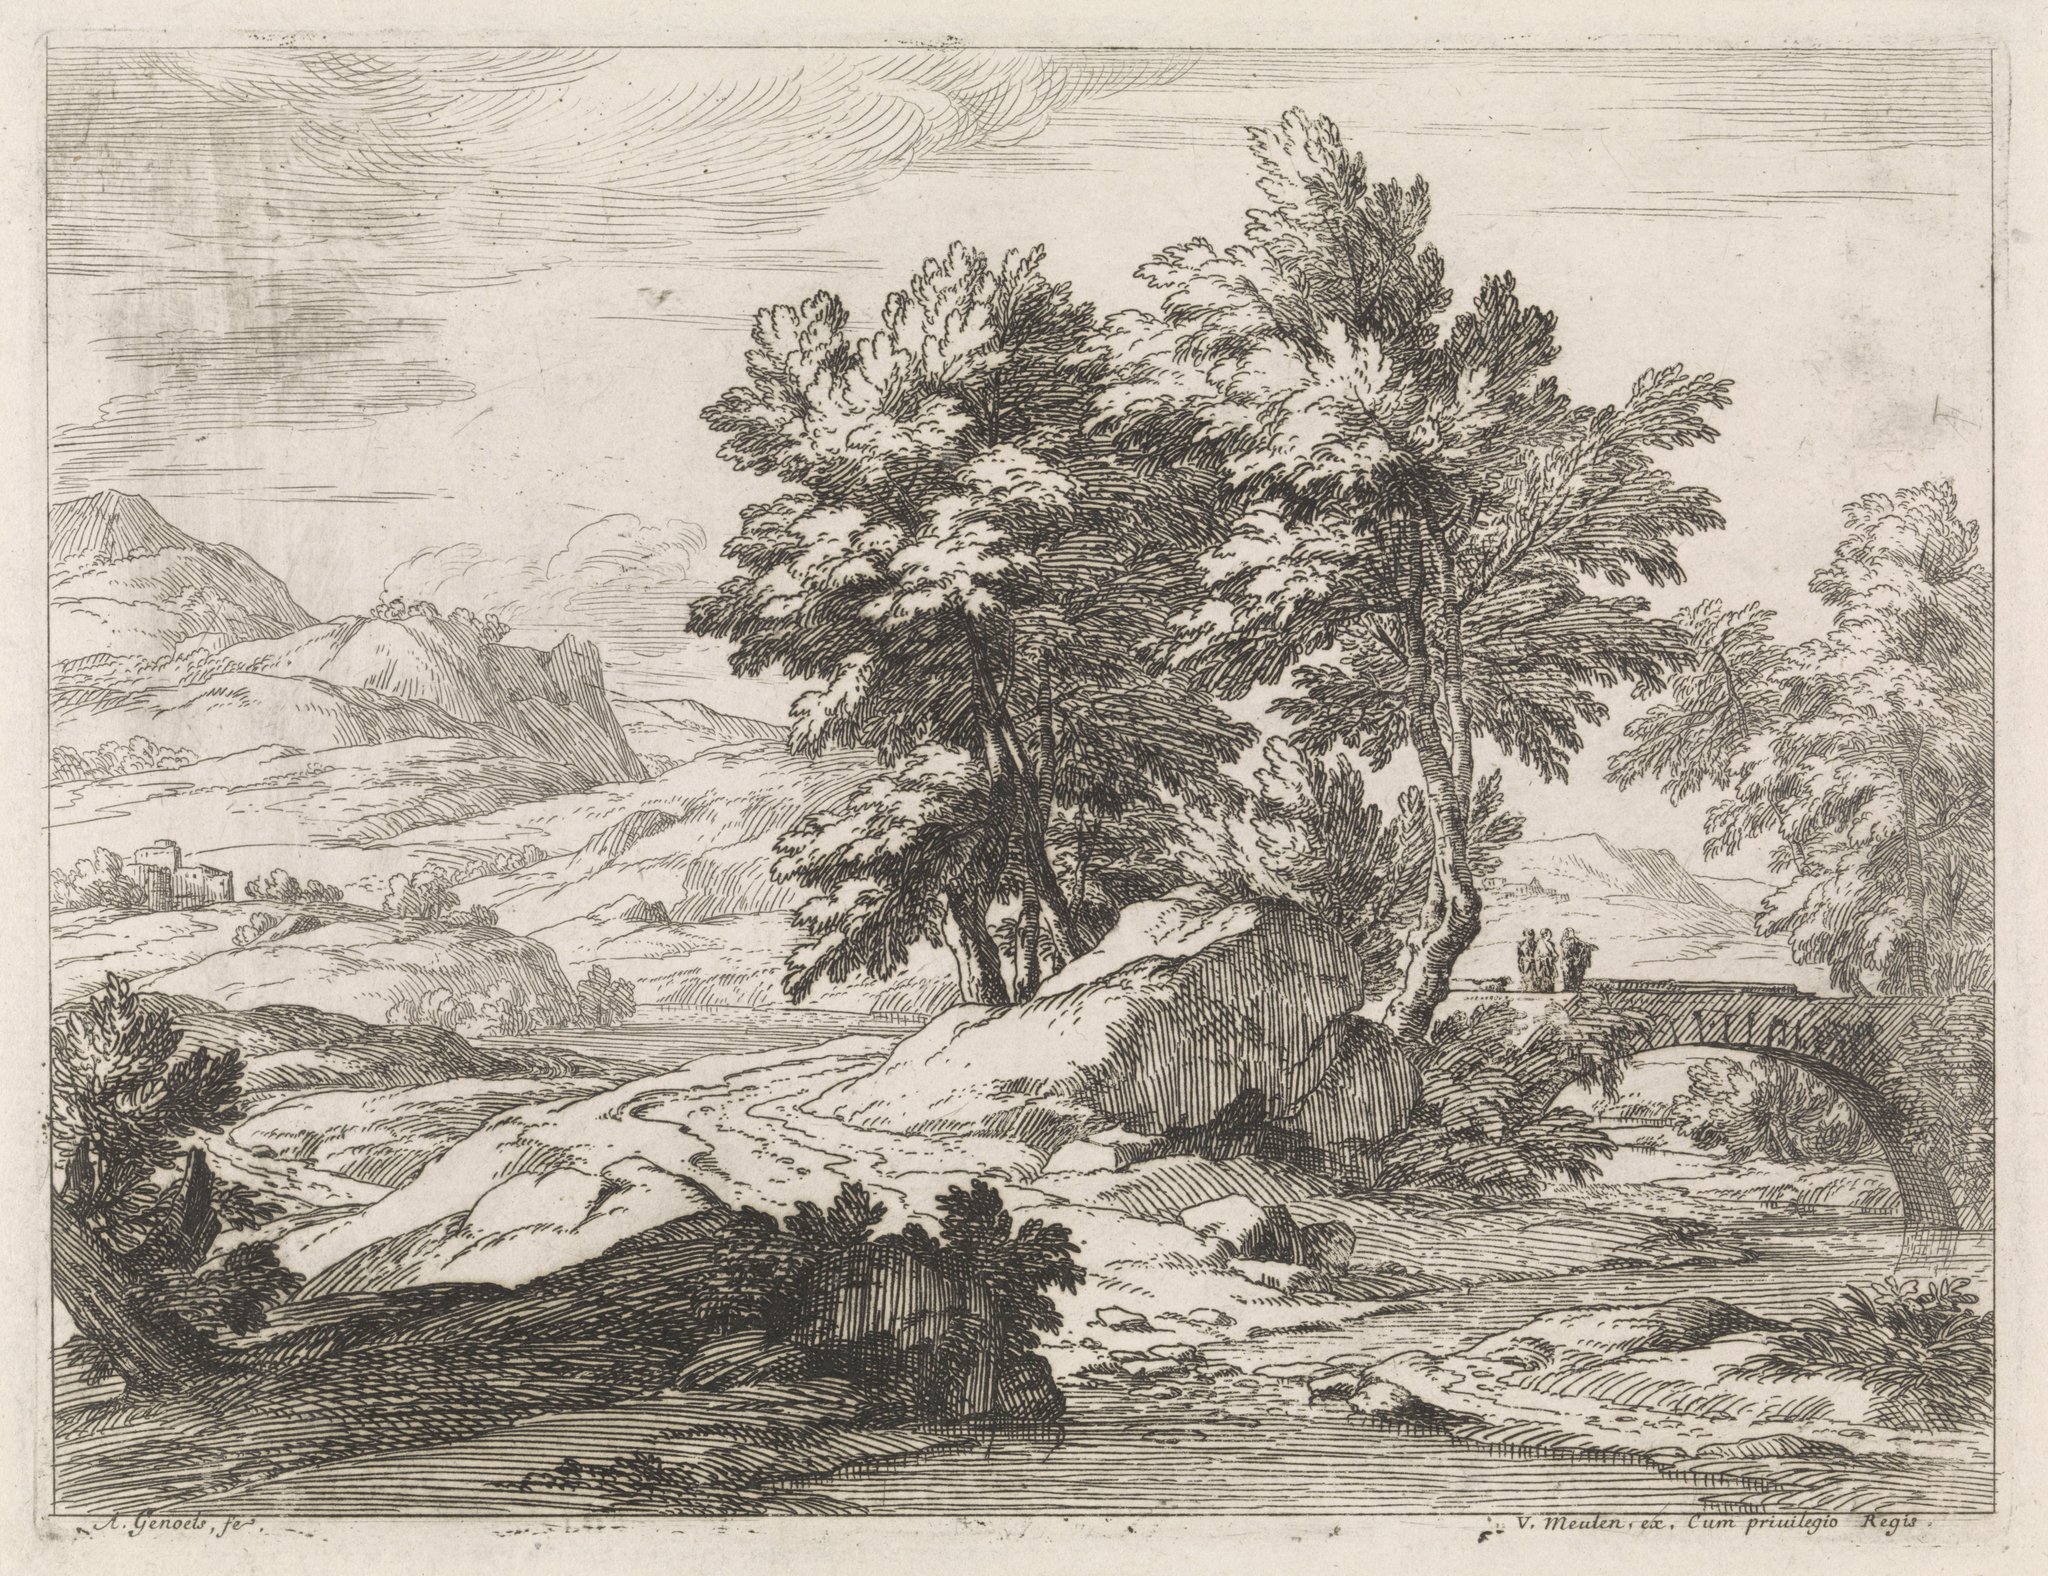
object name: print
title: Rivierlandschap met brug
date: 1650-1690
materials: paper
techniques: etching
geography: paris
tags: river, landscape with bridge, viaduct or aqueduct (+ city(-scape) with figures, staffage), public road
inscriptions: collector's mark: Lugt 240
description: Een heuvelachtig landschap met een rivier. Rechts een brug met drie wandelaars De prent maakt deel uit van een serie van rivierlandschappen.